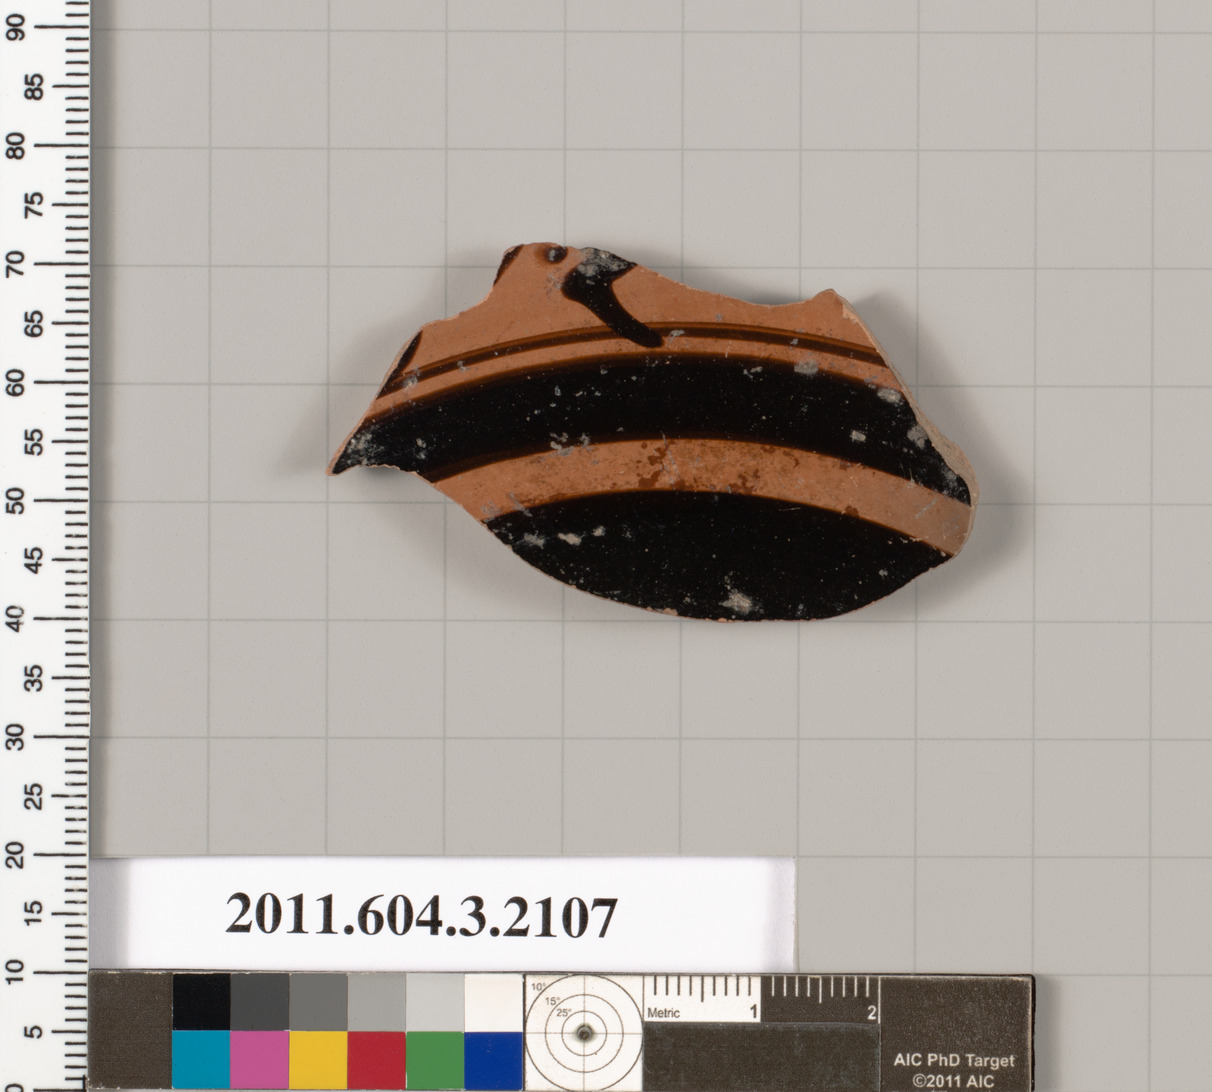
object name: kylix fragment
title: Terracotta fragment of a kylix (drinking cup)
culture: greek, attic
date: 534-468 BCE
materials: terracotta